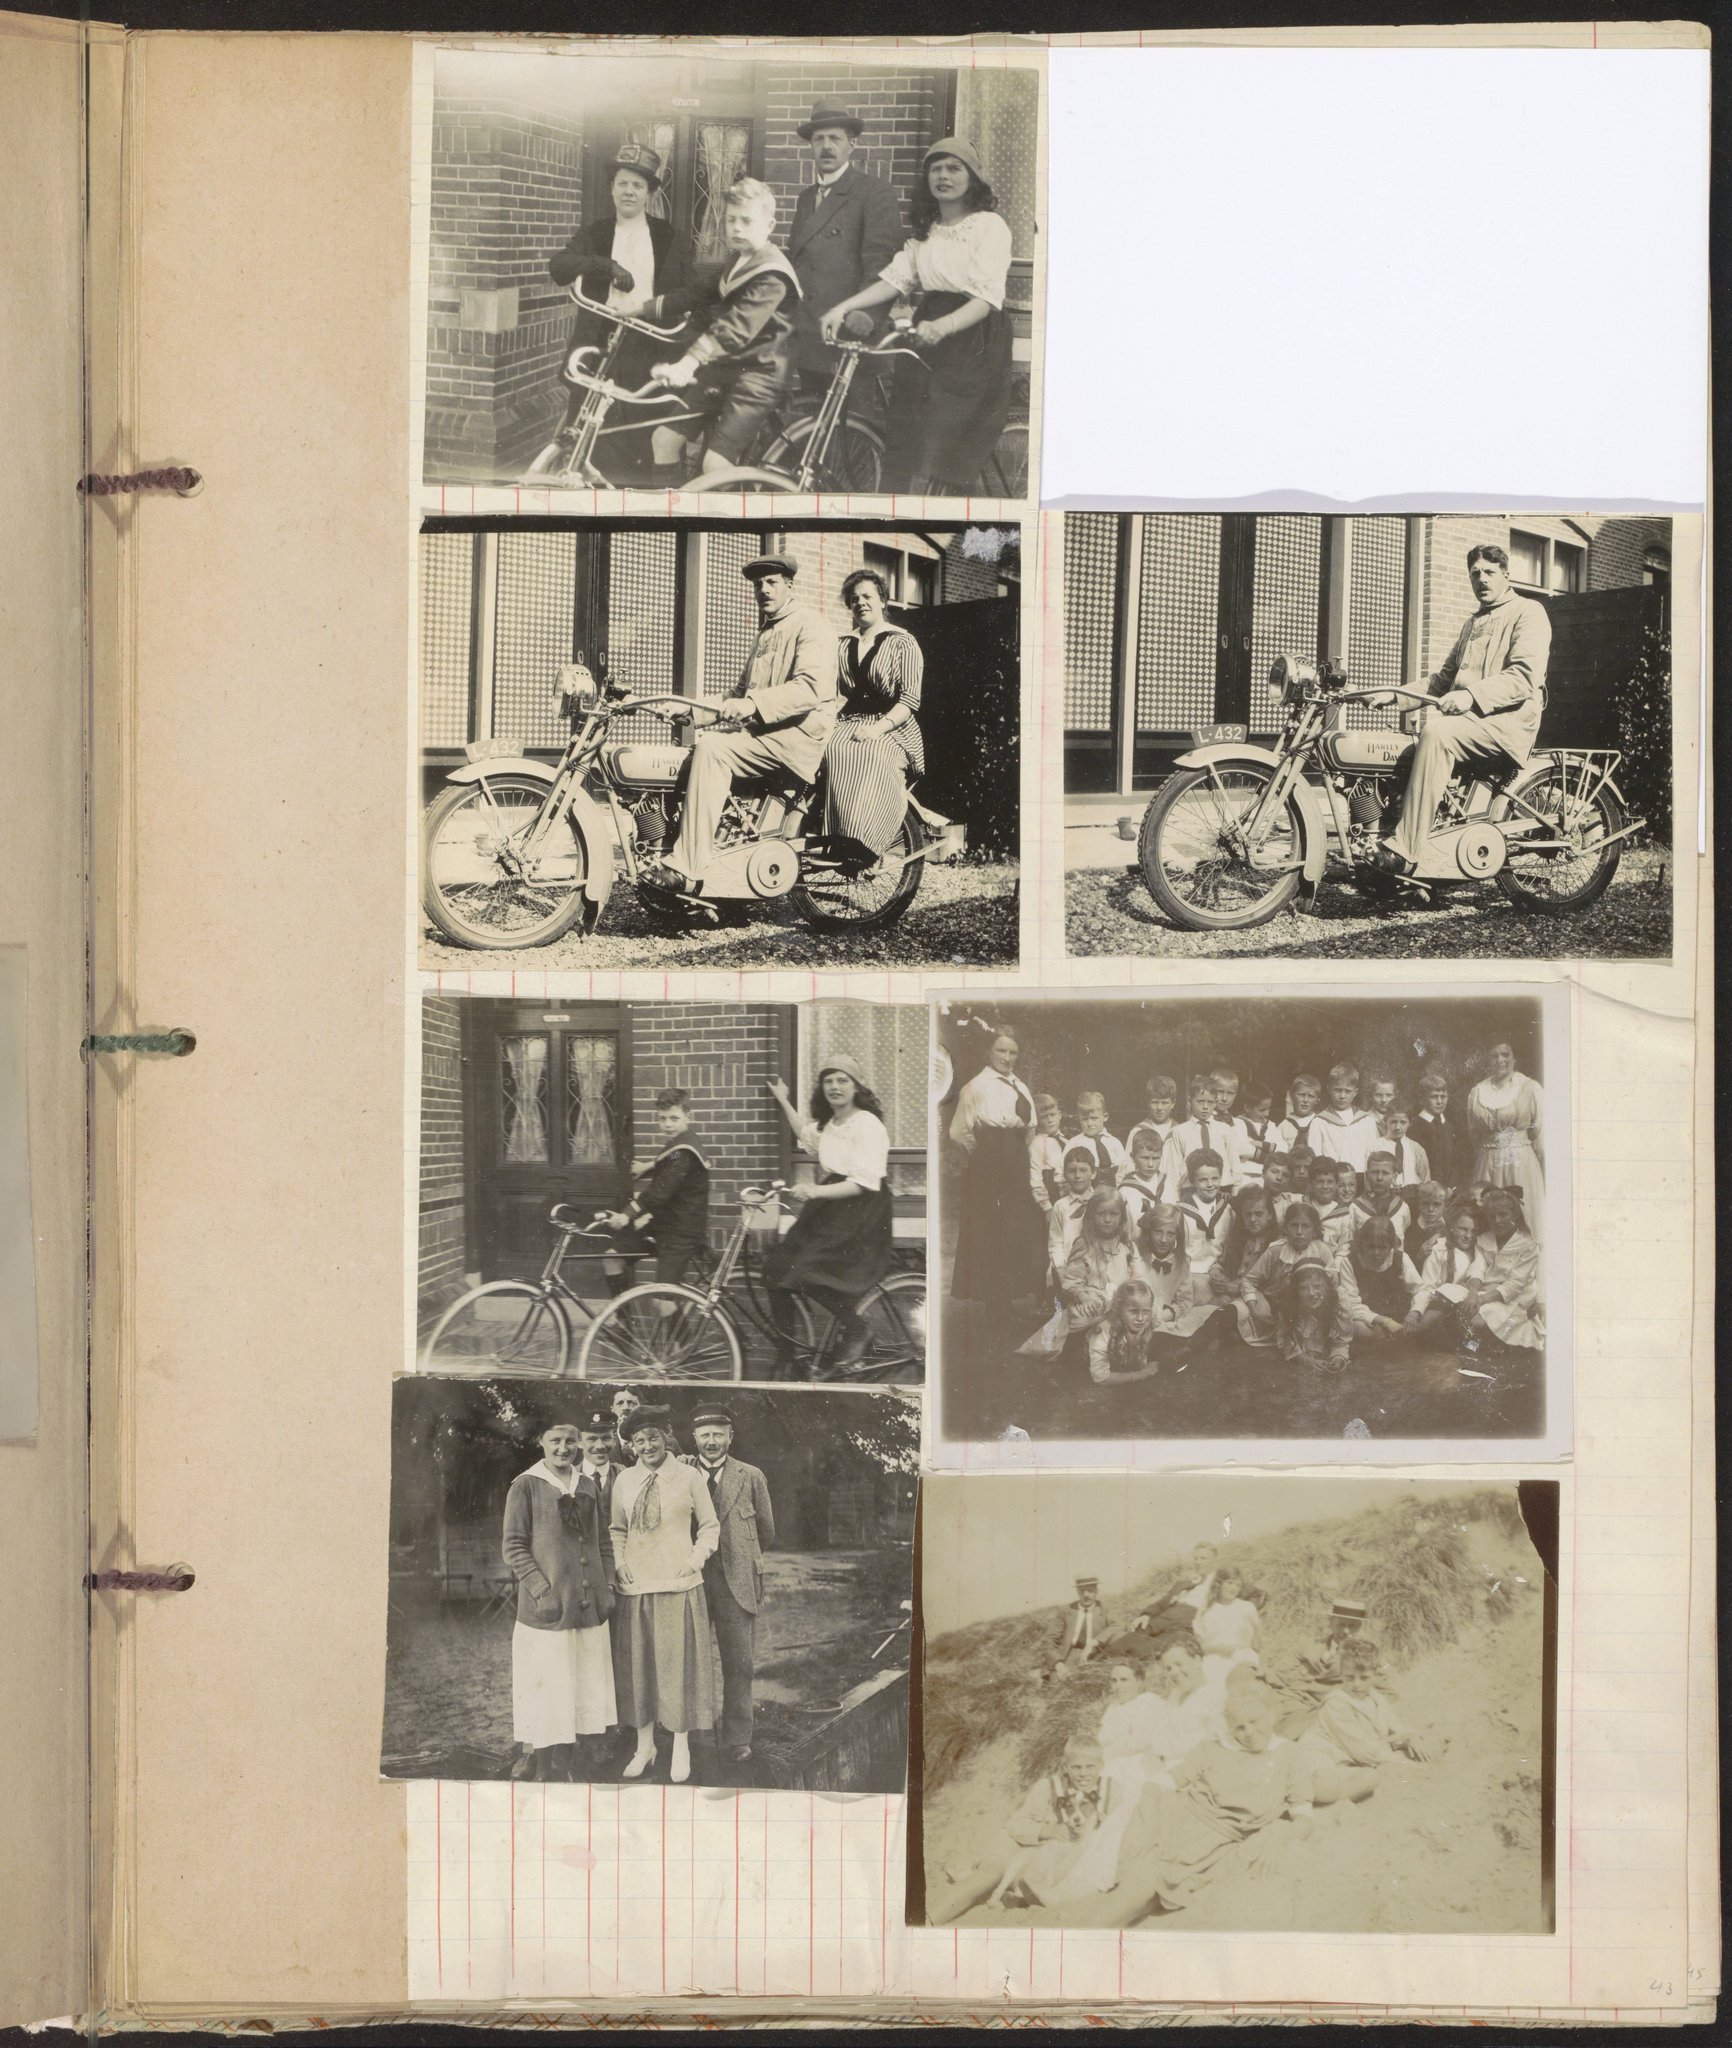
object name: photograph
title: Portretten van onbekende personen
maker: Anonymous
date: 1910-1930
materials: paper, photographic support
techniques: gelatin silver print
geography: netherlands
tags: adult woman, motor-cycles and other two-wheeled motor-vehicles, adult man, child, bicycle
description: Albumblad met portretten van volwassenen en kinderen, onder meer op fietsen en op een motorfiets (Harley Davidson). Onderdeel van Fotoalbum van de familie Petri.